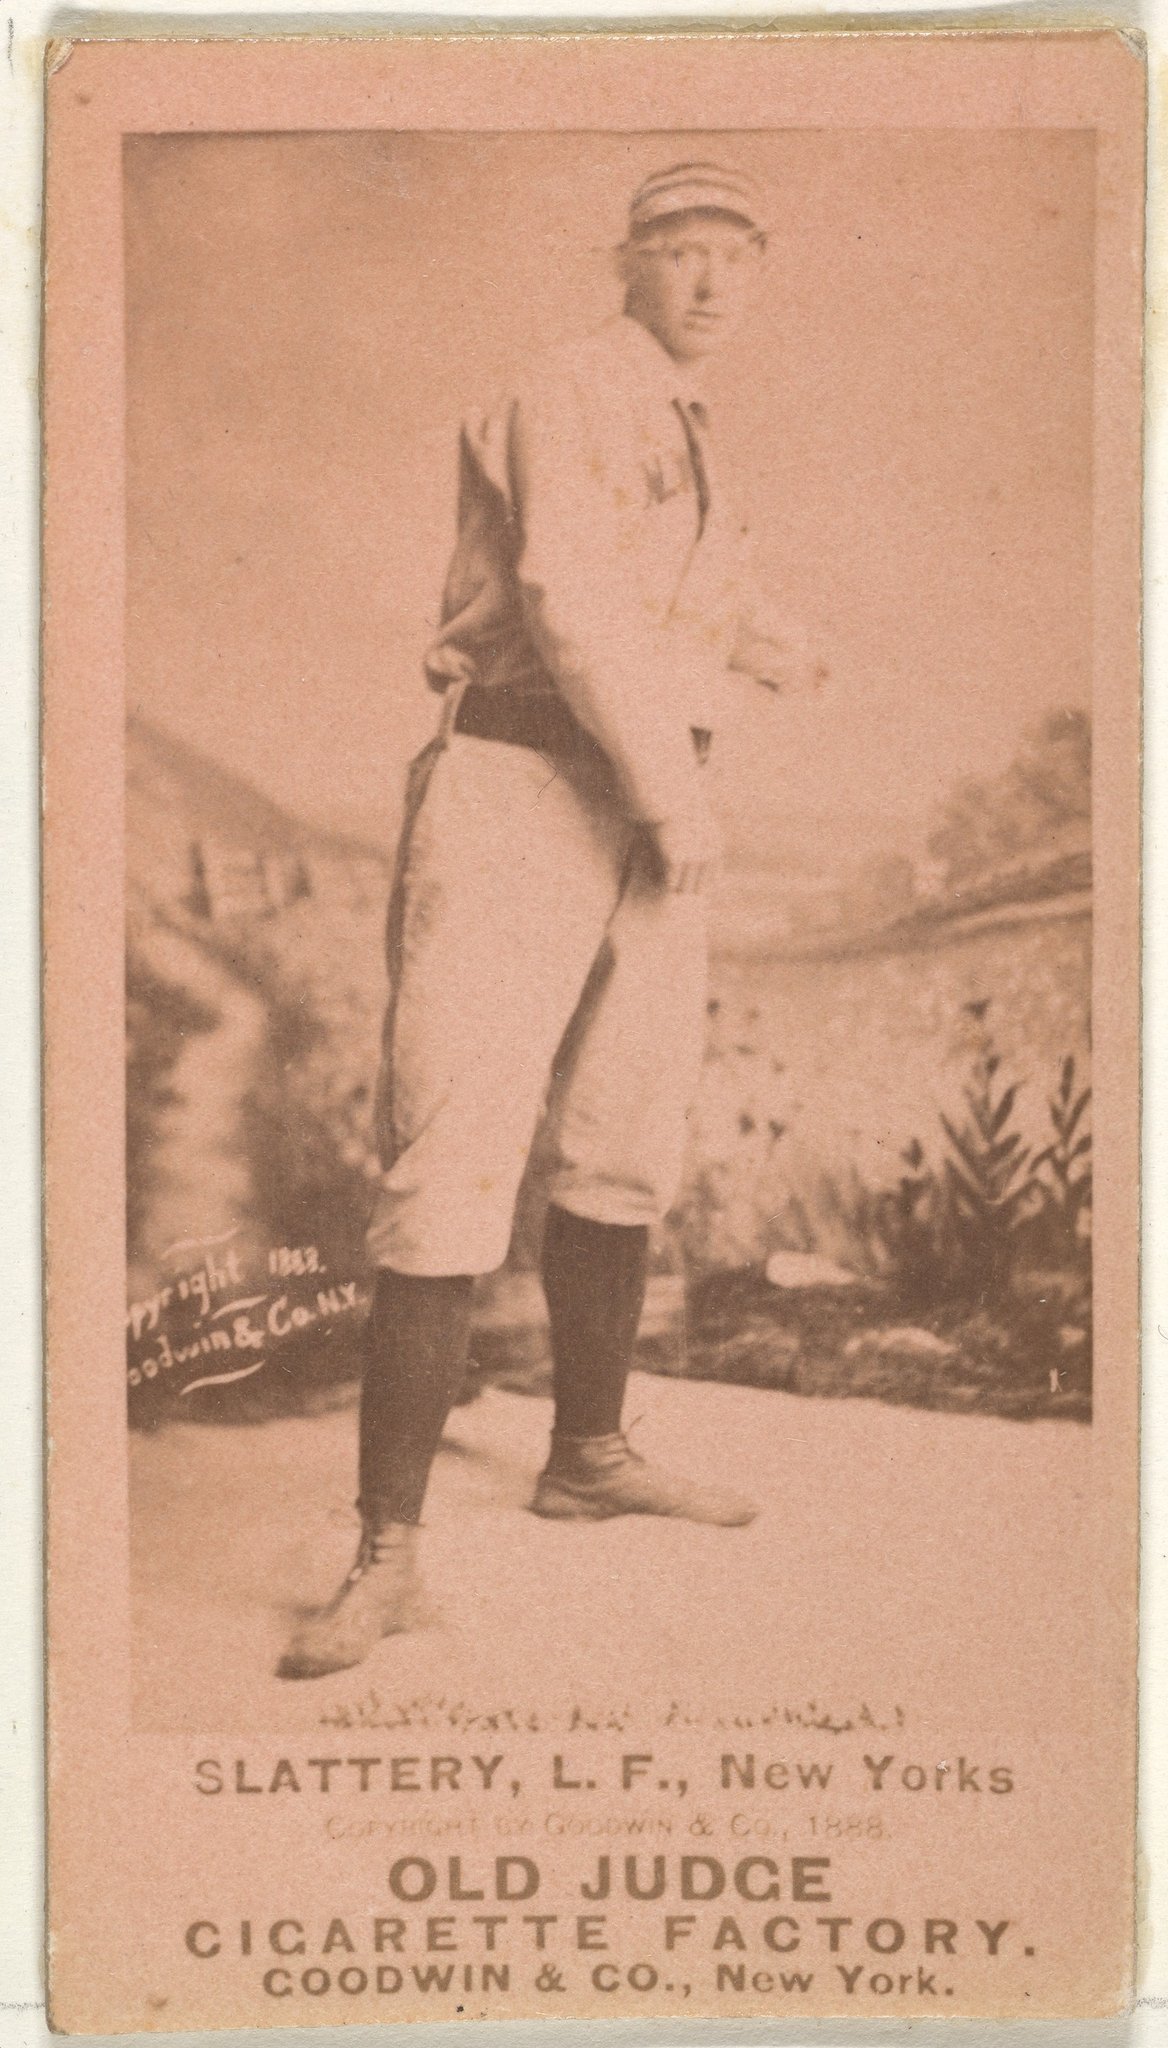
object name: baseball card, photograph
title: Michael J. Slattery, Left Field, New York, from the Old Judge series (N172) for Old Judge Cigarettes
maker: goodwin & company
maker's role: publisher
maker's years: 1850-1950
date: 1888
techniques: albumen silver print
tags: men,portraits,baseball,athletes